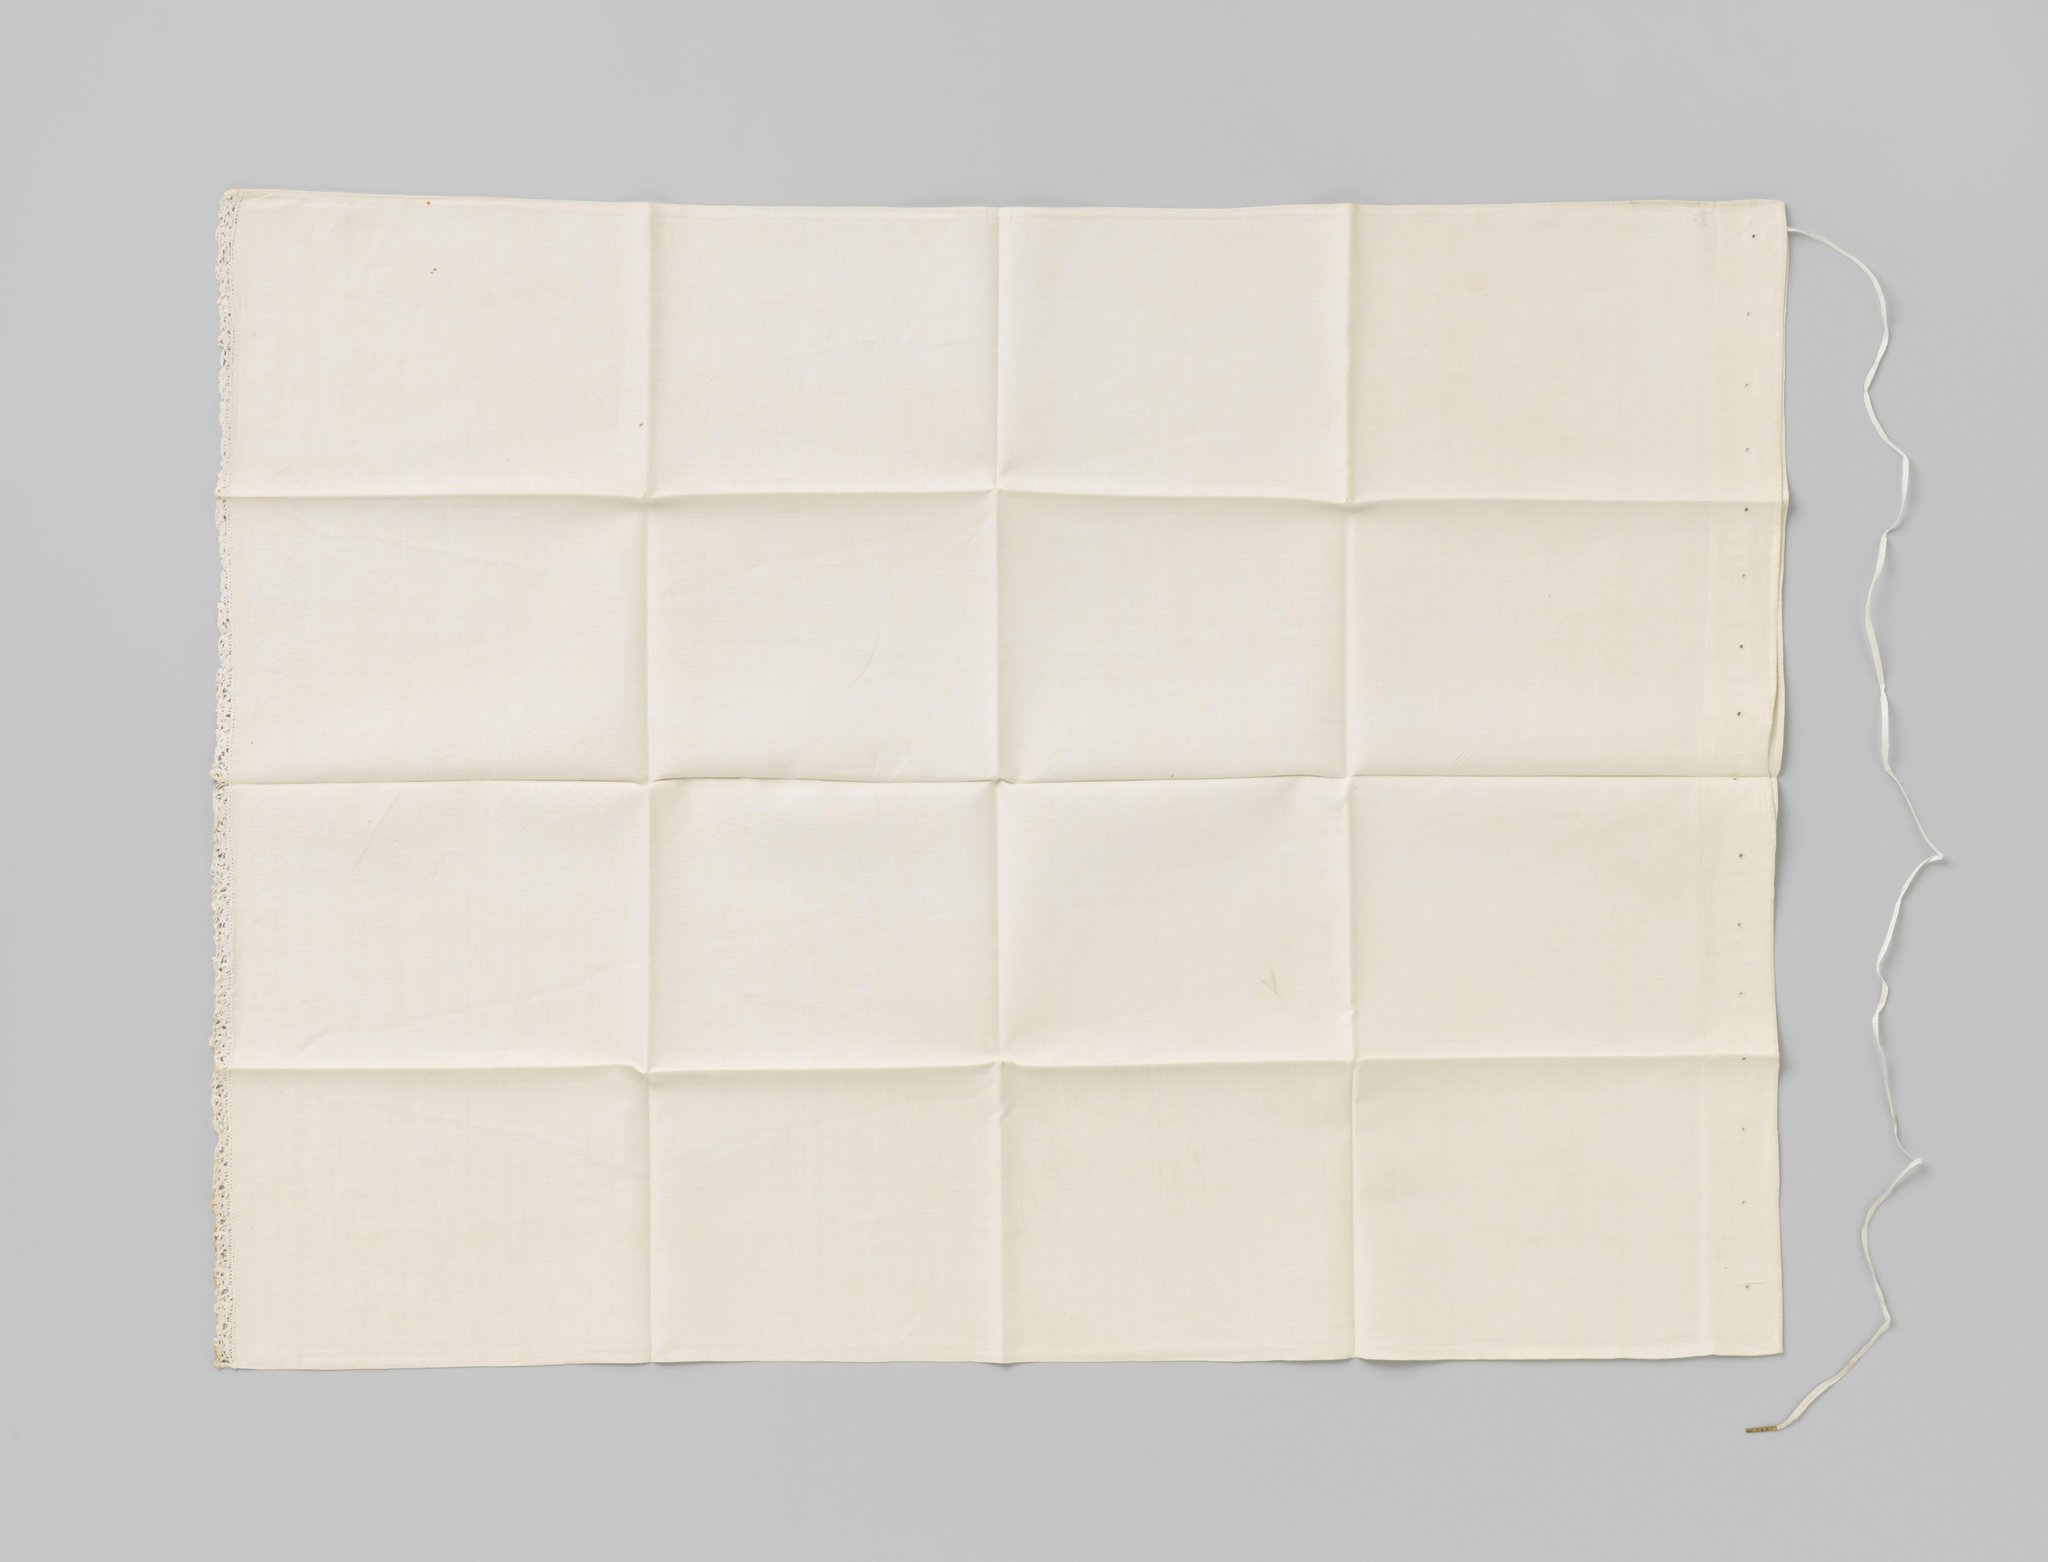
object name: pillowcase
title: Linnen kussensloop met een strook kant.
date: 1400-1950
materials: linen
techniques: weave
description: Linnen kussensloop met langs een zijde een strook kant. Het sloop is gemerkt: HW 18. Bij het sloop hoort een kussensloop met invnr. BK-1980-694-B.